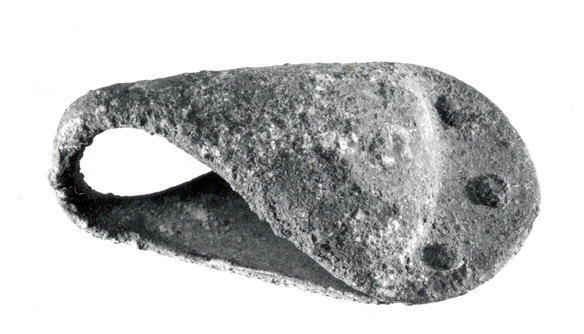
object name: ornament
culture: middle niger civilization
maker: middle niger artist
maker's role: artist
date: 801-1700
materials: copper alloy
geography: mali